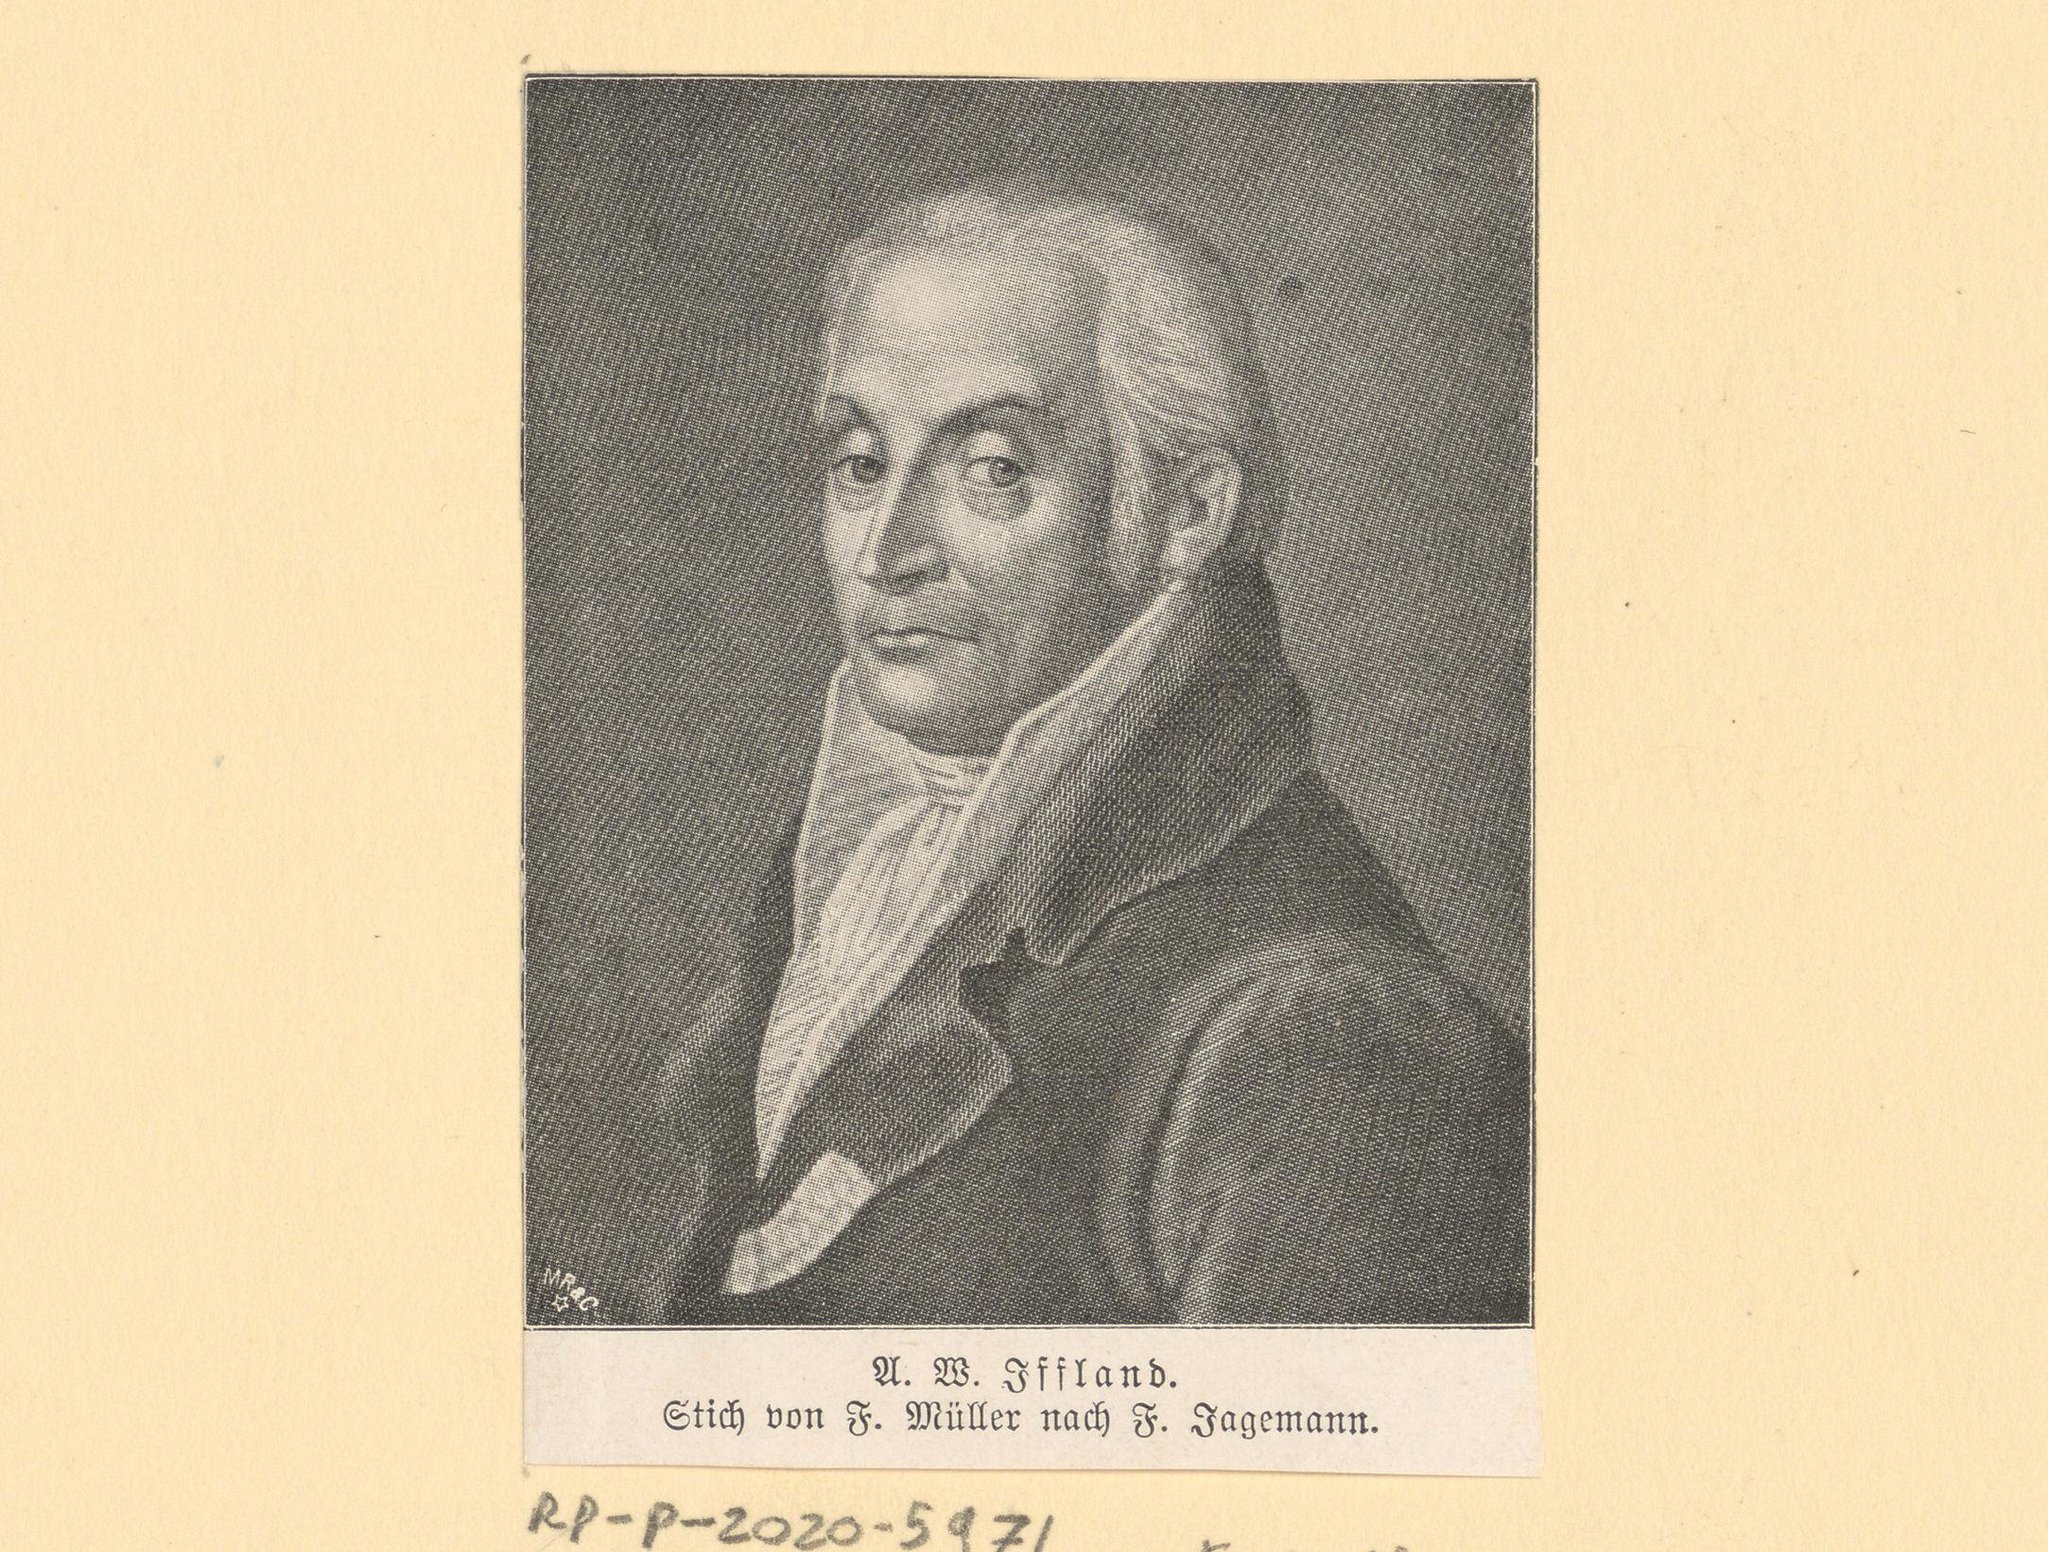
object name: photomechanical print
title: Portret van August Wilhelm Iffland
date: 1905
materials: paper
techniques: letterpress printing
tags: historical persons, portrait of a writer, portrait of actor, actress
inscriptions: monogram: ‘MR&C’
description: Prent uit: Veldhagen & Klasings Monatshefte 19 (1904), p. 447.